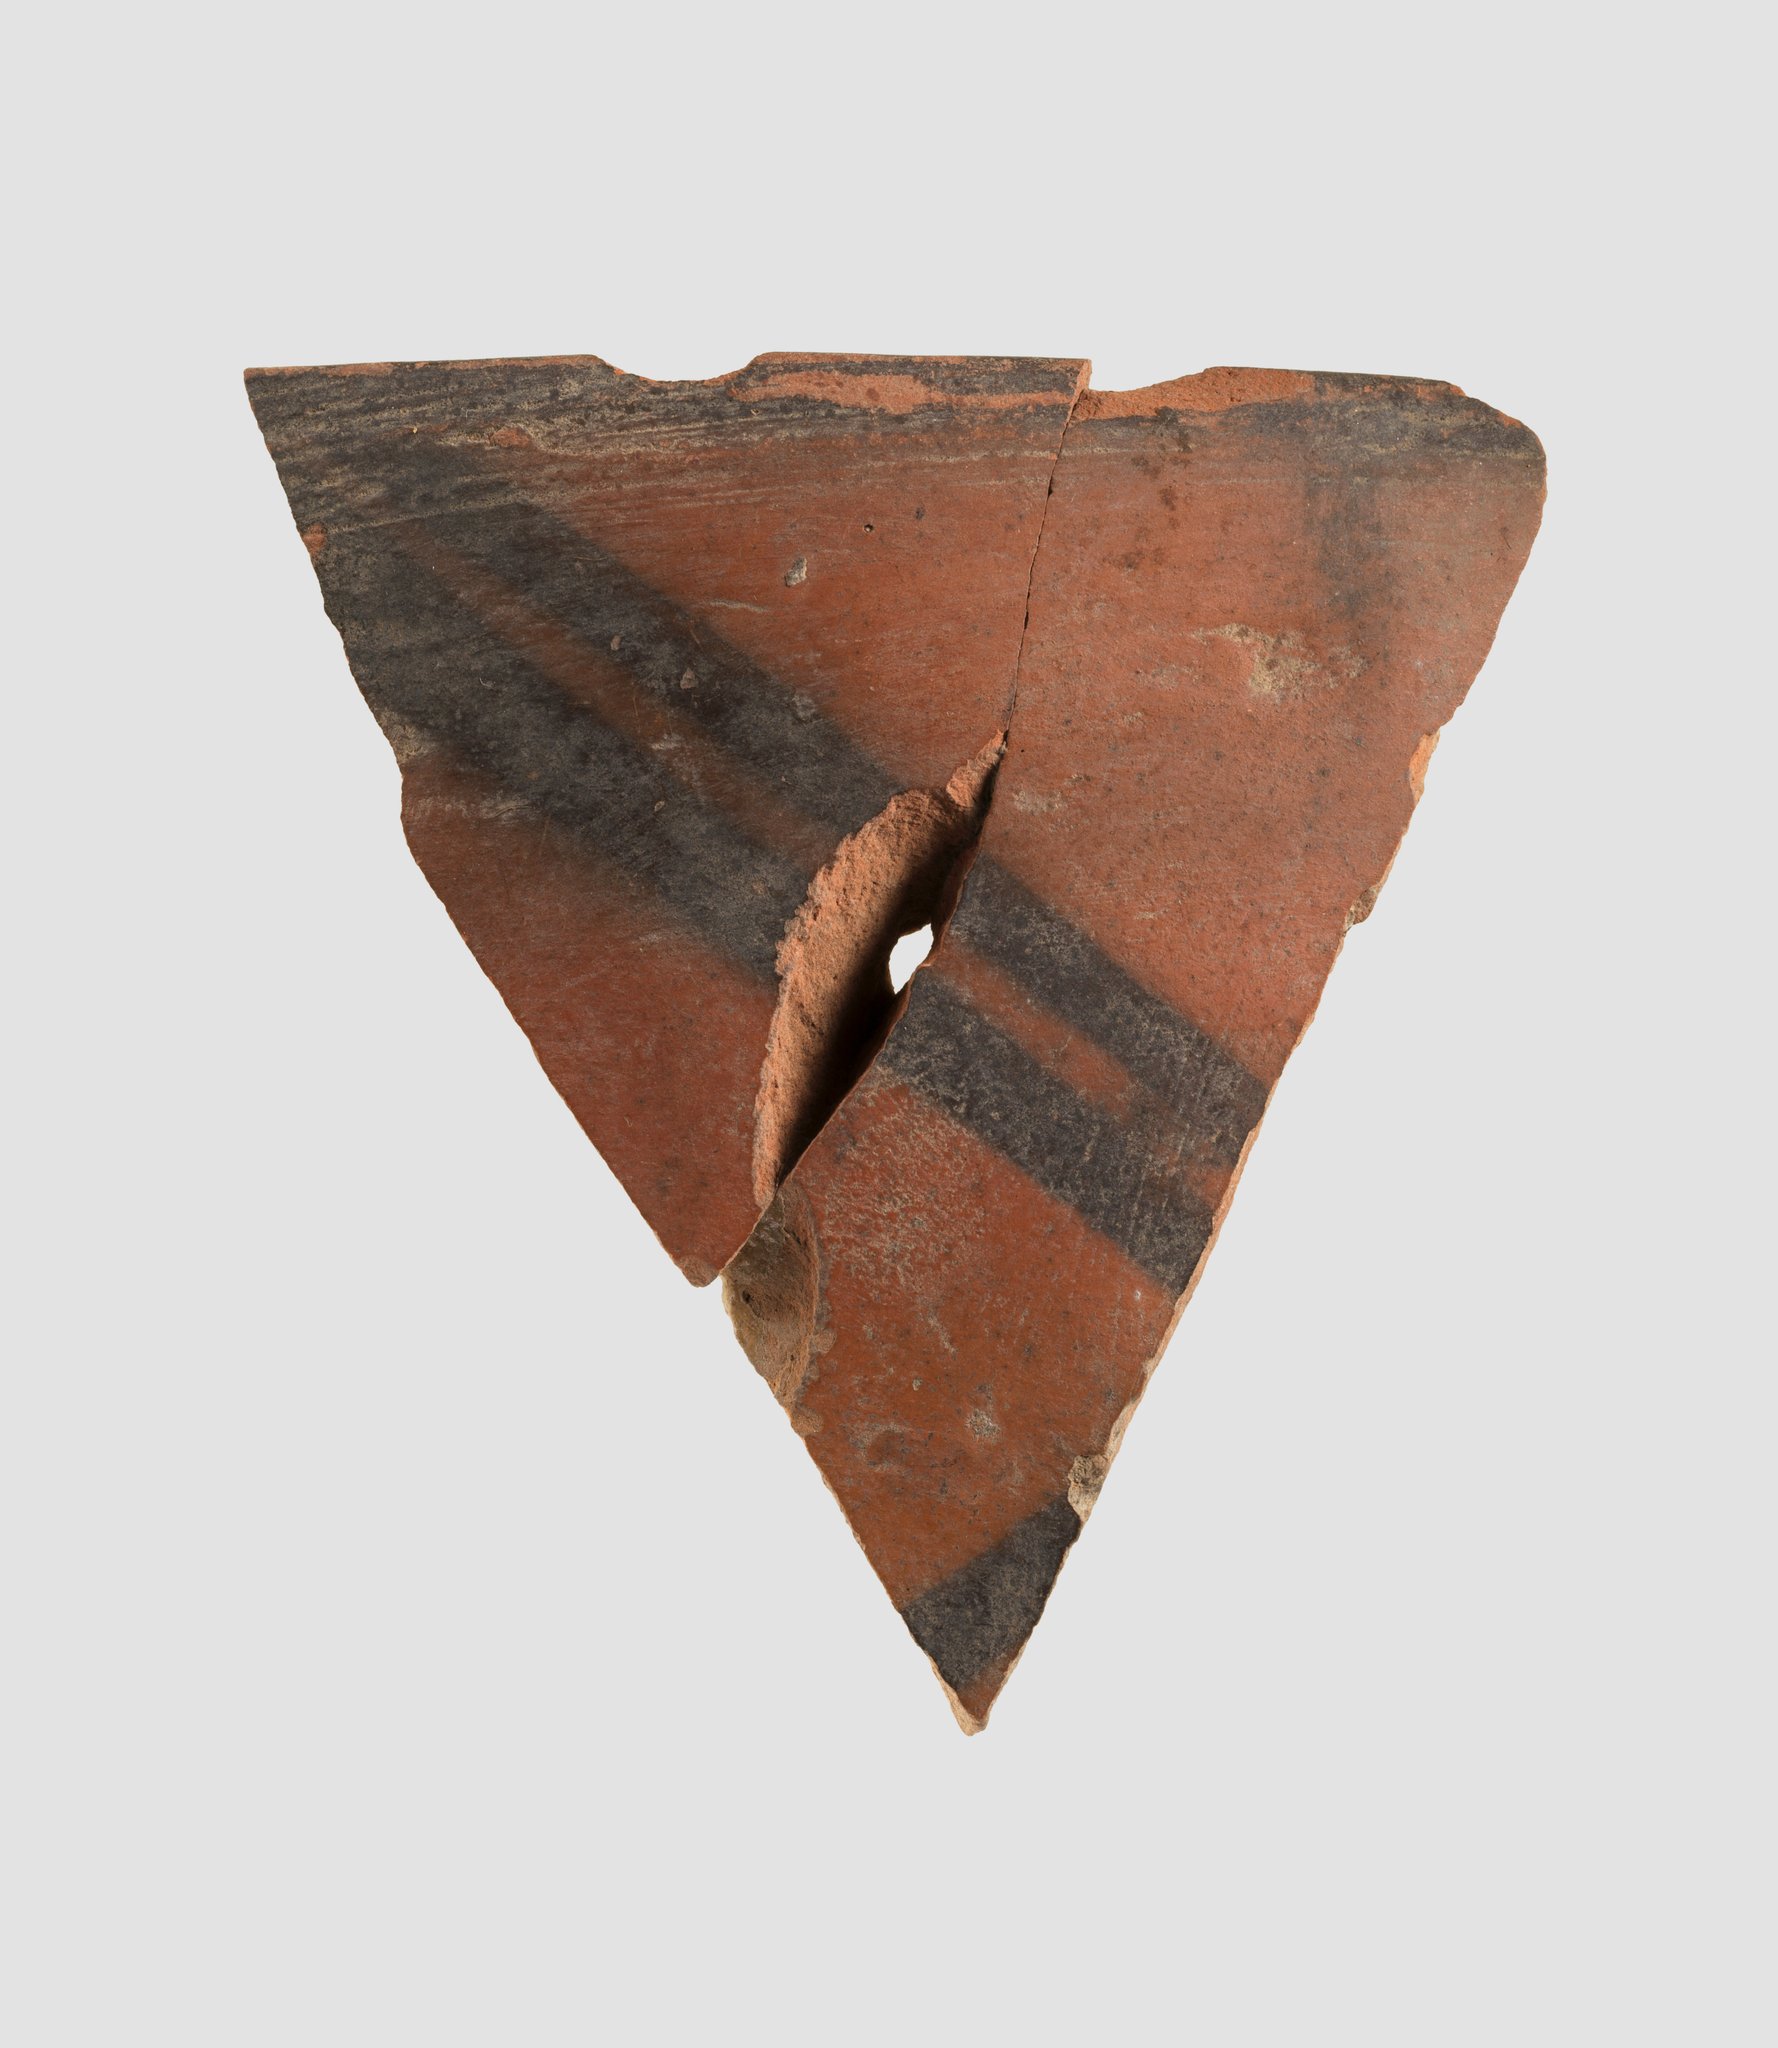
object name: sherd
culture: iranian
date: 4000-3500 BCE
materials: ceramic, glaze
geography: iran